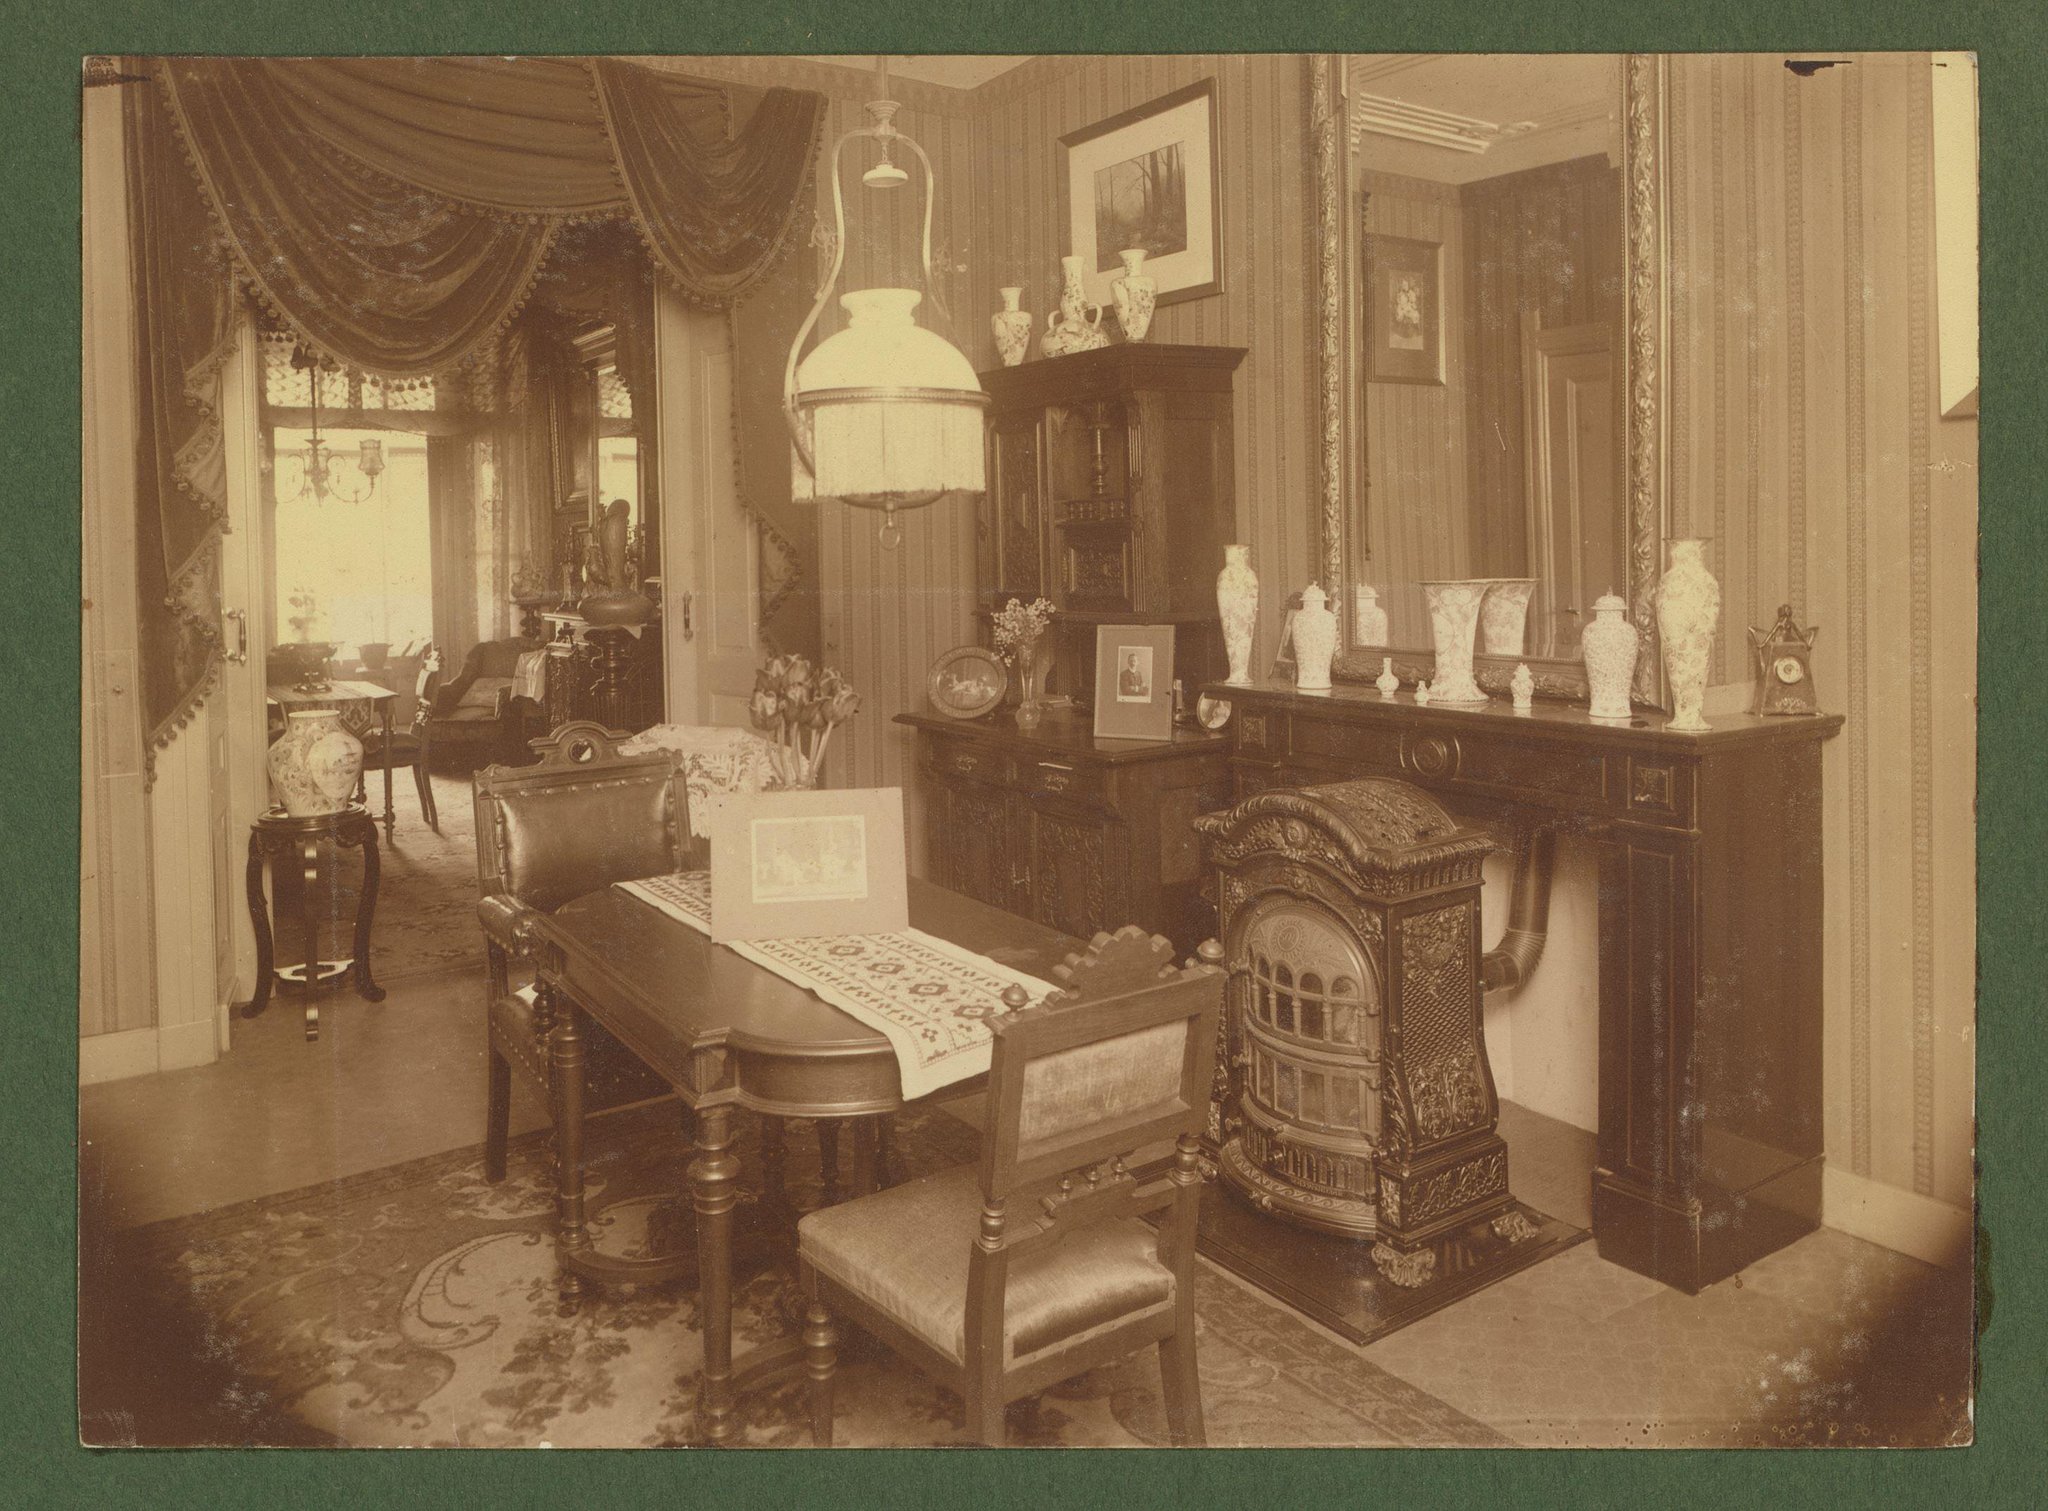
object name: photograph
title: Interieur van de woning van de familie Vermeulen aan de Toussaintkade te Den Haag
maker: cornelis johannes lodewicus vermeulen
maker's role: fotograaf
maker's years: 1861-1936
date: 1910-1915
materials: photographic support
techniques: gelatin silver print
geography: the hague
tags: interior of the house, living-room, parlour, sitting-room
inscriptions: annotation: ‘Kamers Toussaintkade’